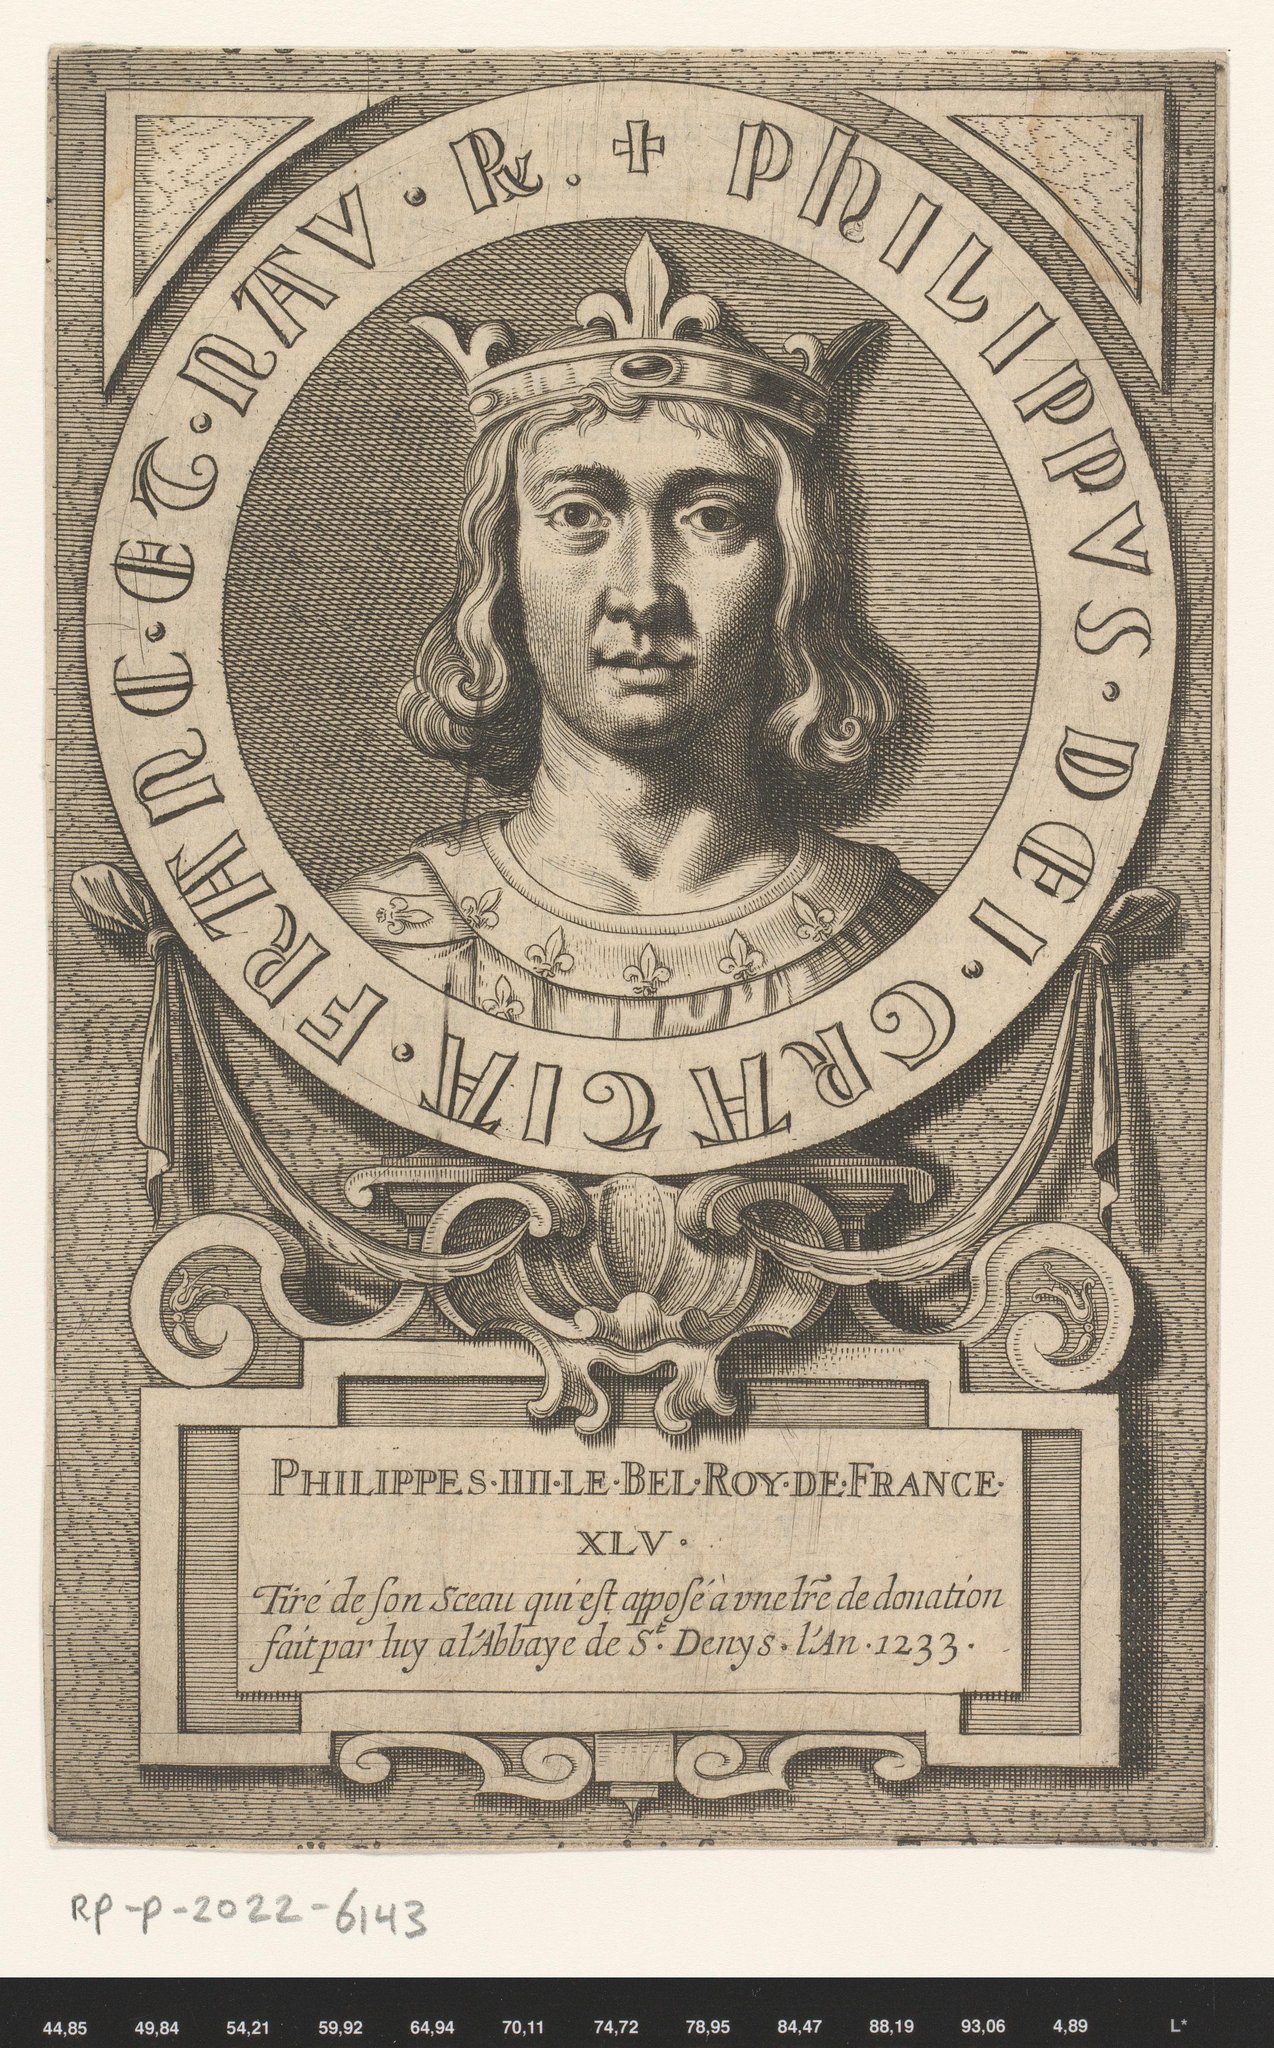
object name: print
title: Portret van Filips IV van Frankrijk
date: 1636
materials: paper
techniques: engraving, letterpress printing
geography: paris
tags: historical persons, king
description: Prent uit: Bie, Jacob de. Les vrais portraits des rois de France. (...) Parijs: Jean Camusat, 1636, dl. 2, p. 253.